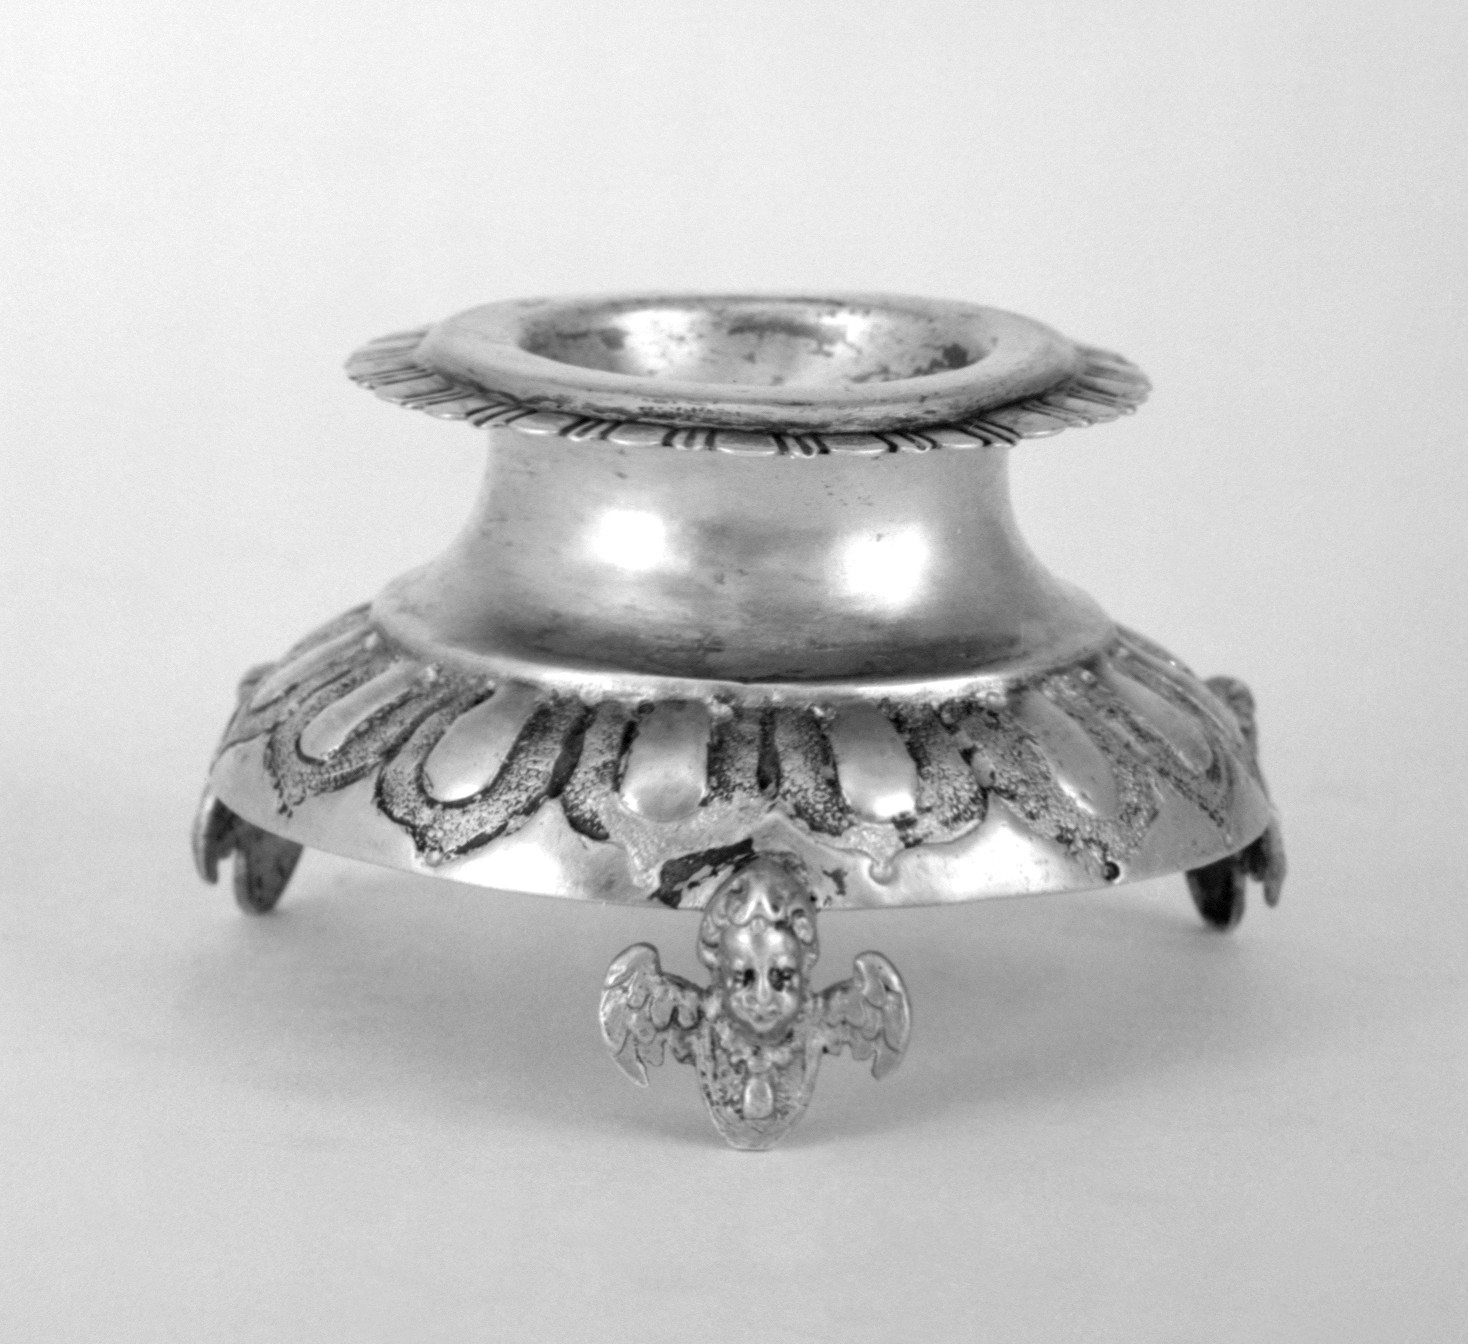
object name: salt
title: Circular salt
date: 1610-1625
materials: silver gilt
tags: heads